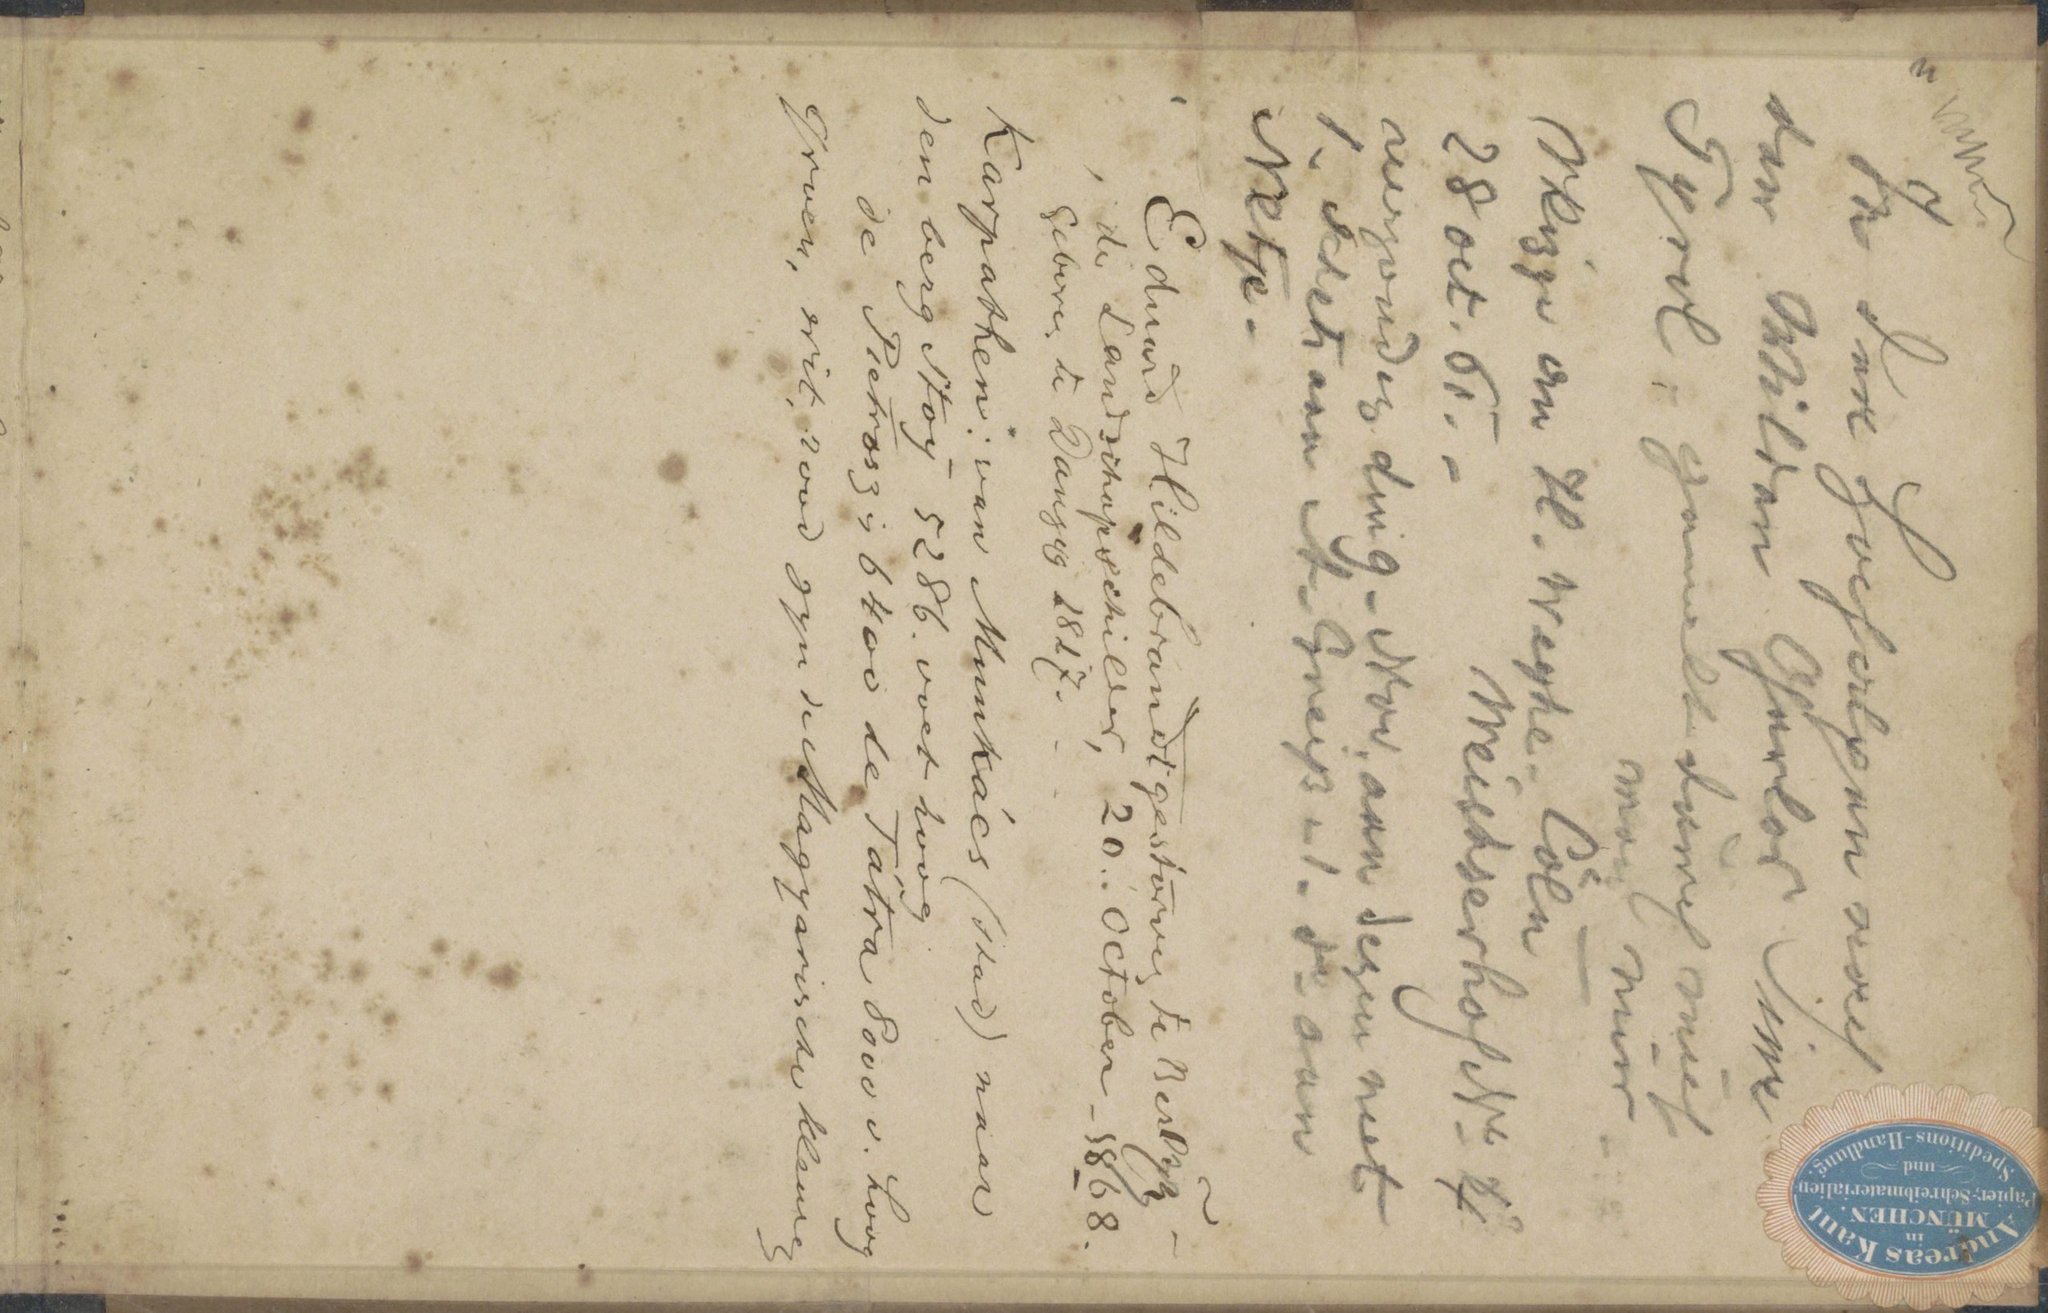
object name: sketchbook leaf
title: Notities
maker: johannes tavenraat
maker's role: draughtsman, painter, print maker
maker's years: 1809-1881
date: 1858-1869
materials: ink, paper, pencil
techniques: pen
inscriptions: retailer's mark: ‘Andreas Kaut/ in/ MÜNCHEN/ Papier-, Schreibmaterialien/ und/ Speditions - Handlung.’, annotation: ‘[...]’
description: Achterste schutblad uit een schetsboek met 48 bladen.